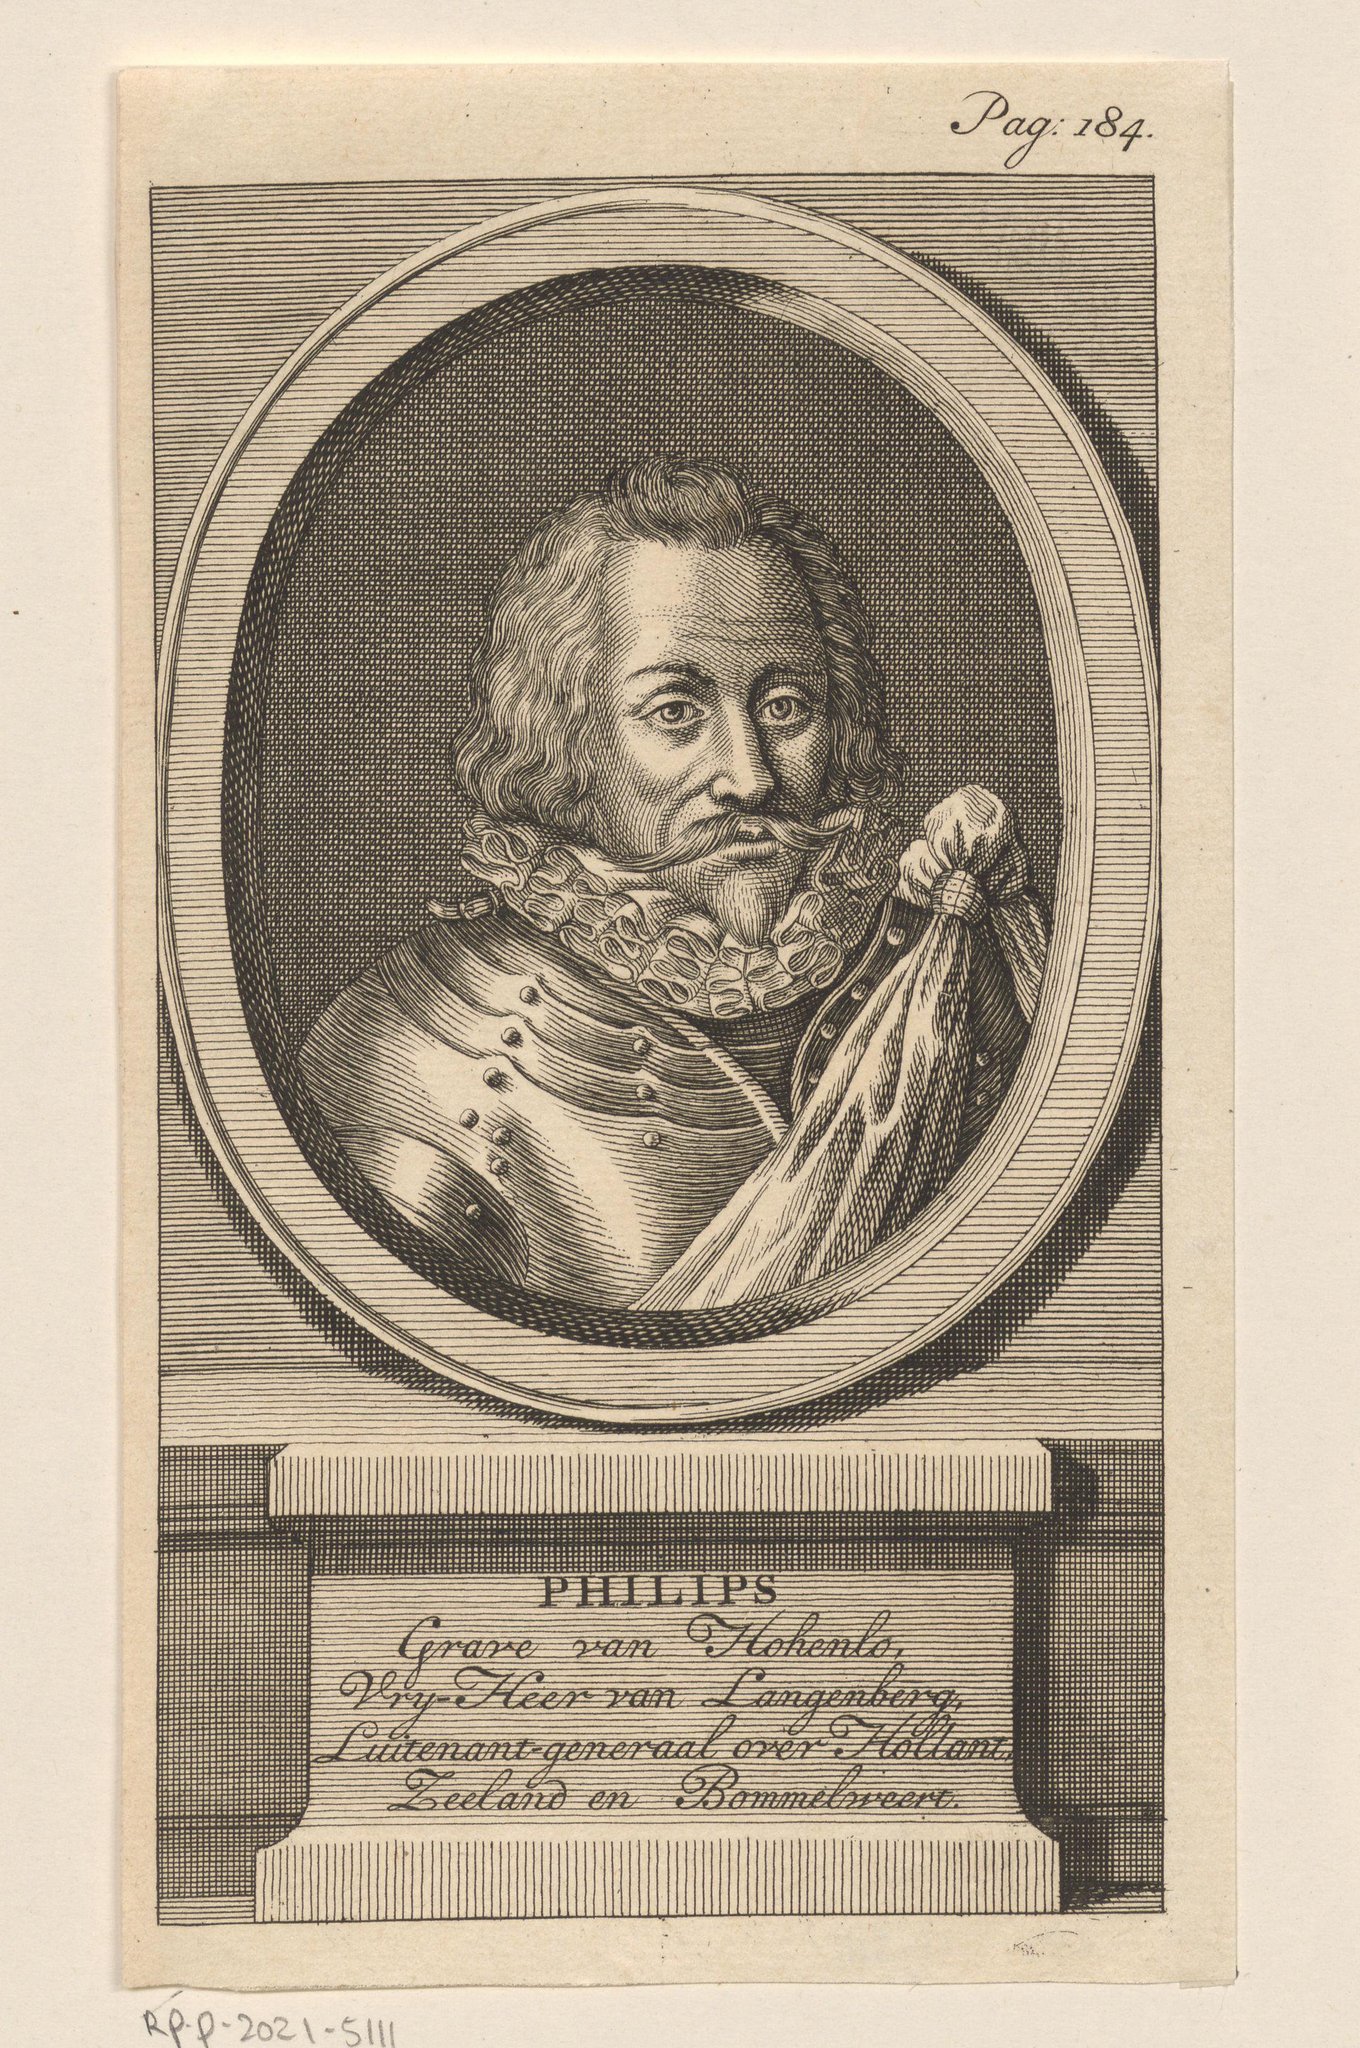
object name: print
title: Portret van Filips, graaf van Hohenlohe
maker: christian friedrich fritzsch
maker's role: print maker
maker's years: 1719-1774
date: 1729-1774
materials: paper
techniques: engraving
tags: moustache, adult man, historical persons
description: Prent mogelijk gebruikt in een editie of vertaling van Emanuel van Meterens 'Nederlantsche historien'.